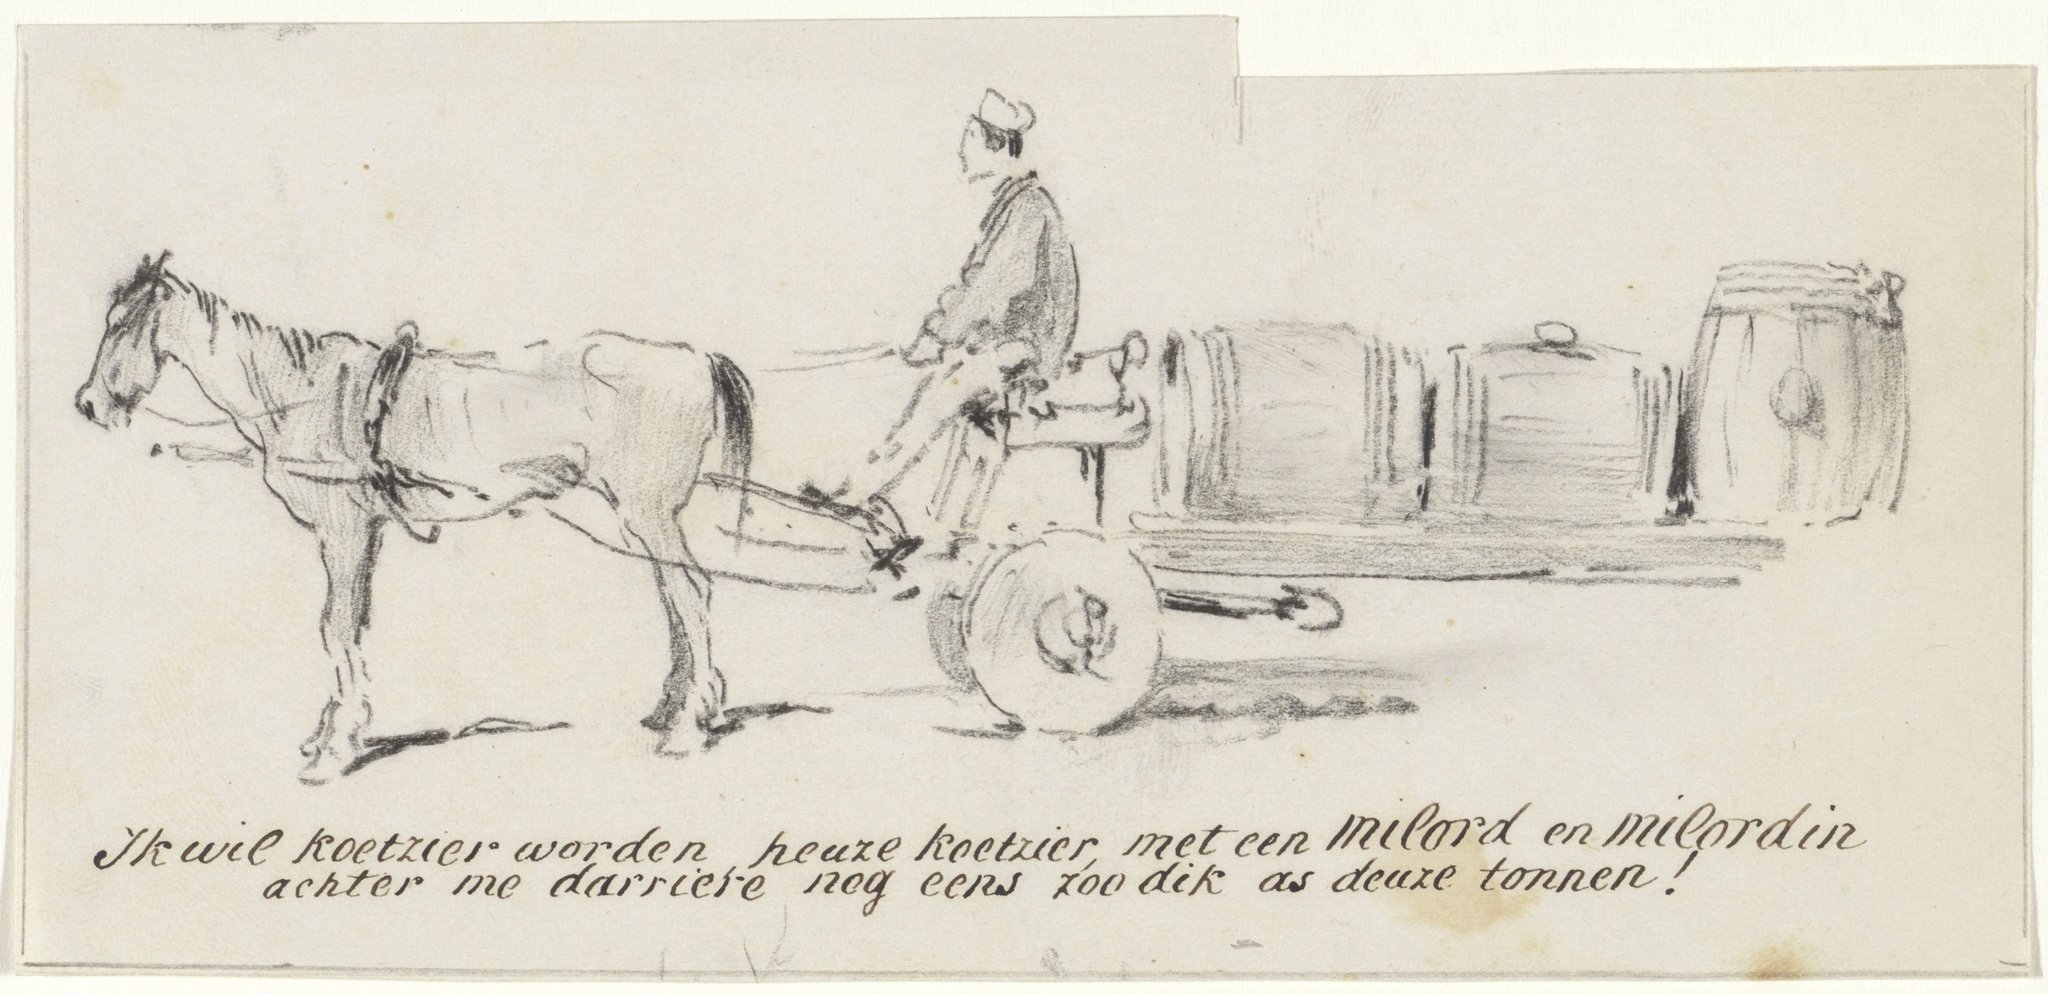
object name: drawing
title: Paard en wagen met voerman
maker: pieter van loon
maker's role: draughtsman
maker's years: 1801-1873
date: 1811-1873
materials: chalk, paper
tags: (farm) wagon, freight wagon, cart